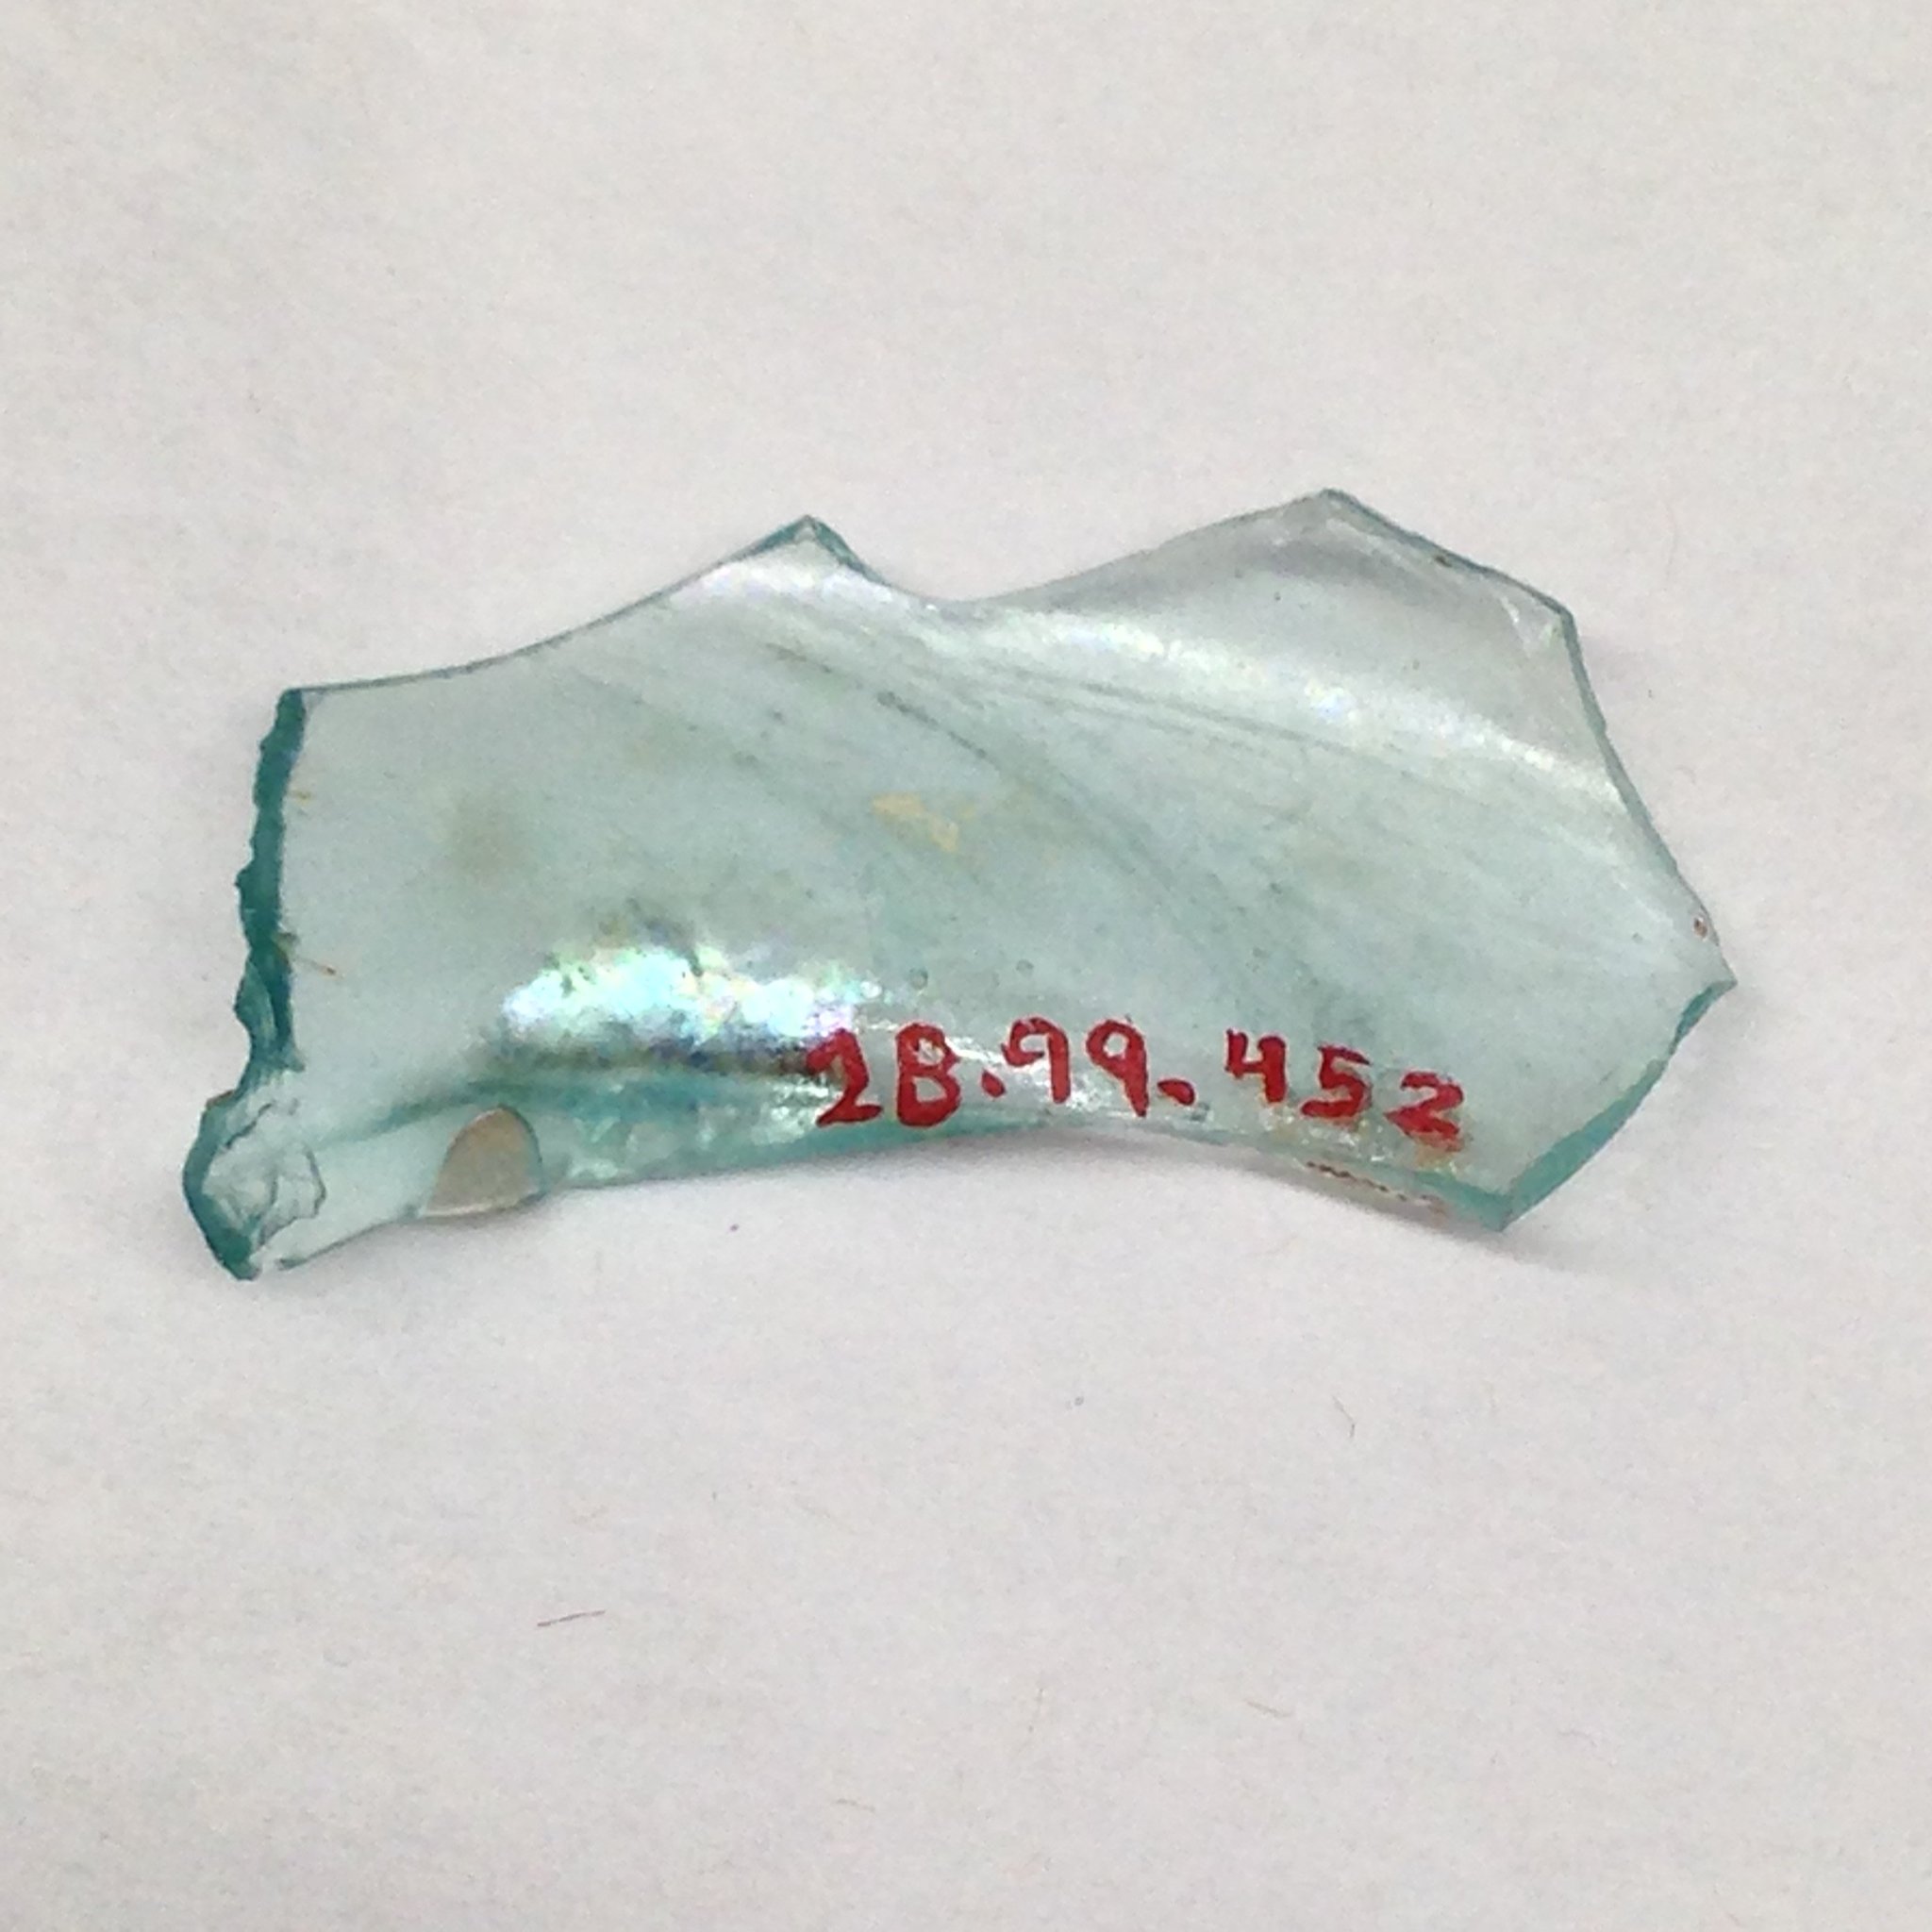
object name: fragment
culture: european or middle eastern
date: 1150-1250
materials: ceramic, glass